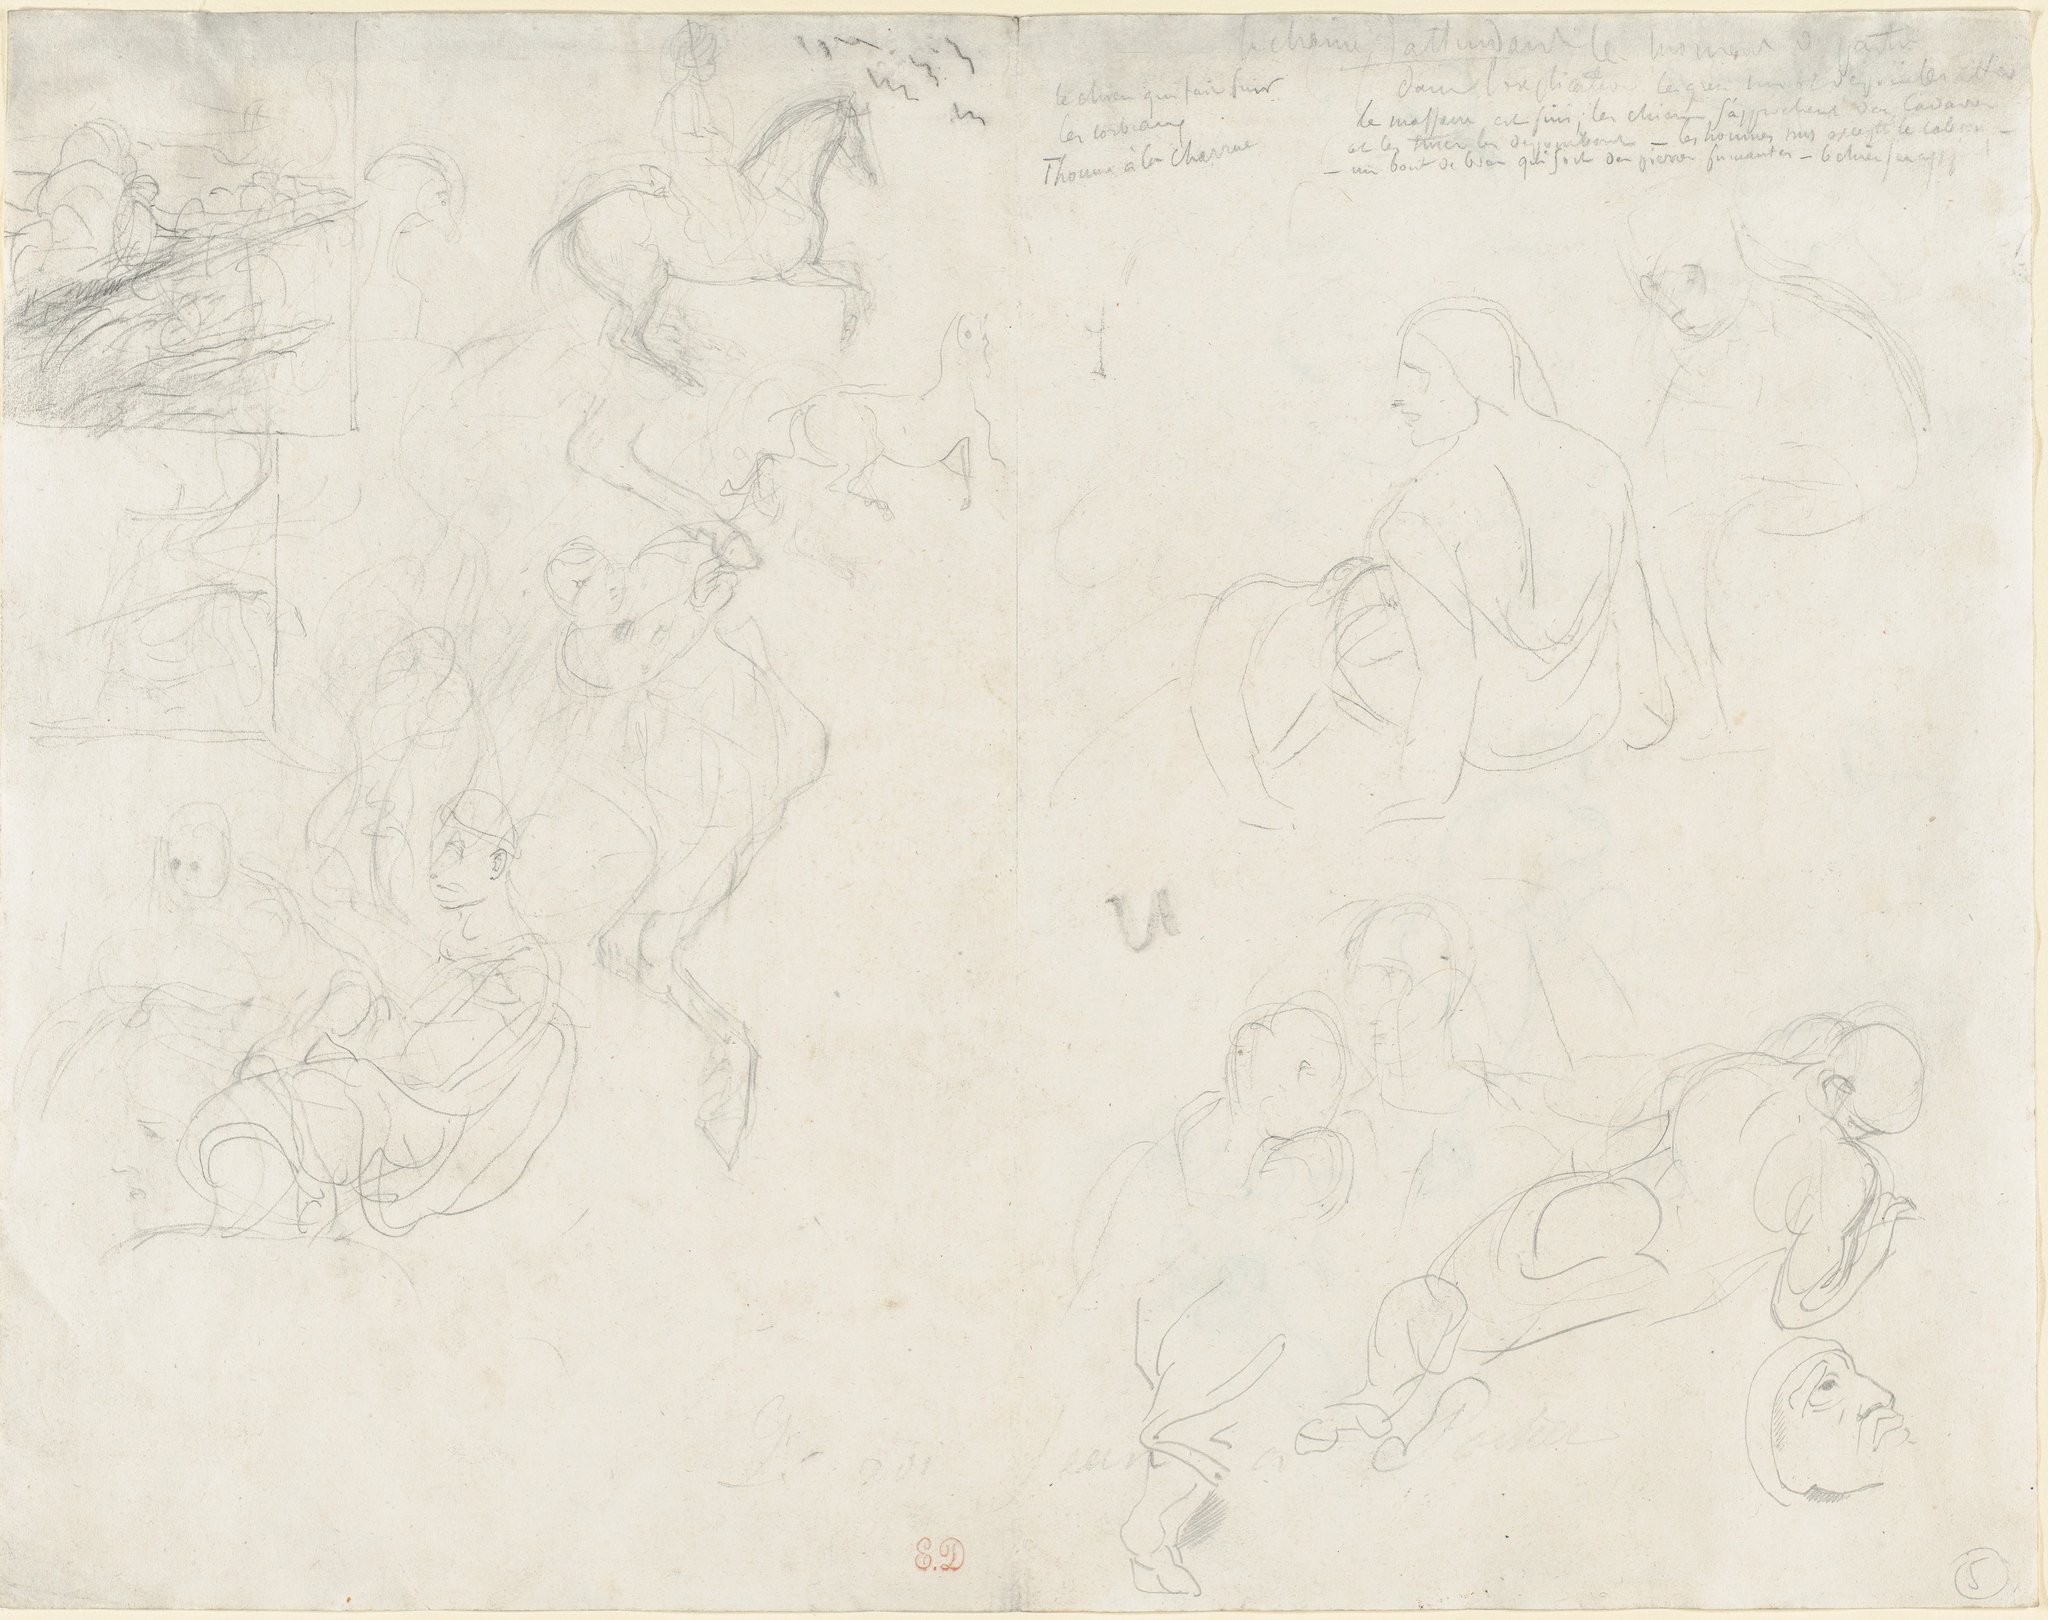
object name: drawing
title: Studies of Figures and Horses (recto); Figure Studies (verso)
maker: eugène delacroix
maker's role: artist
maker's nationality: french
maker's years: 1798-1863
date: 1824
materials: graphite